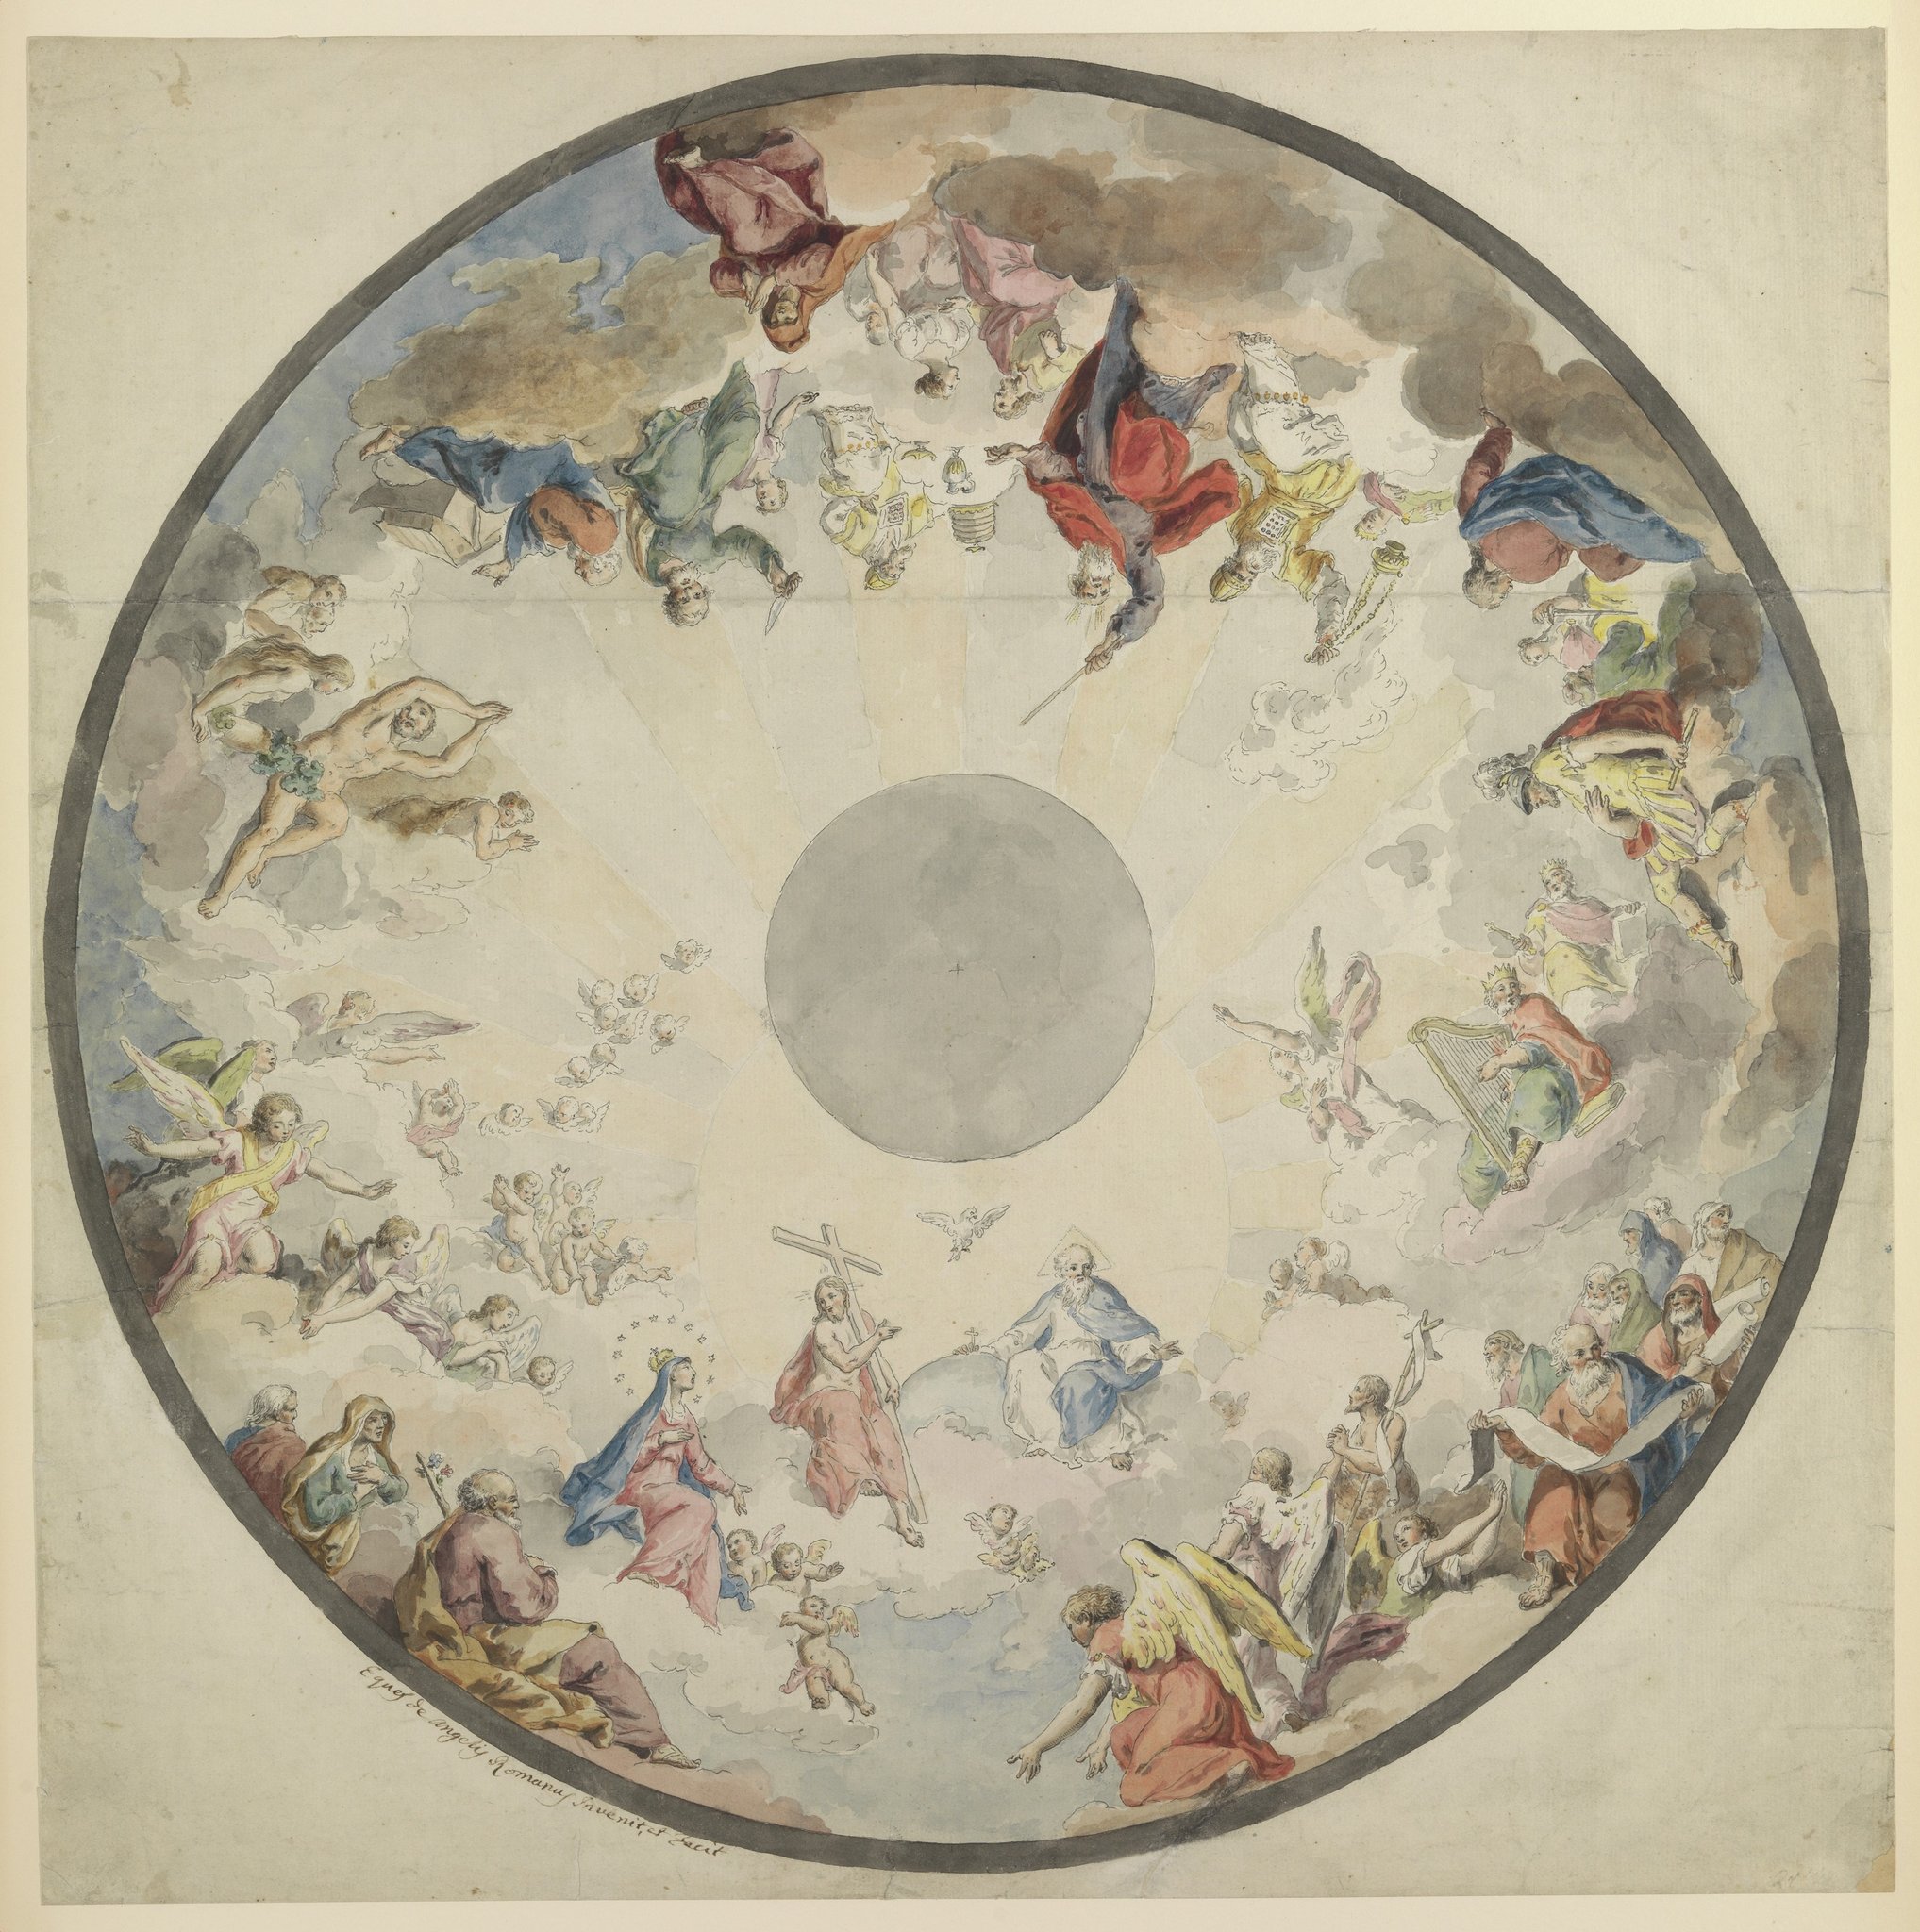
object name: drawing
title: Design for a Cupola with Old and New Testament Figures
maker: pietro de angelis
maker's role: artist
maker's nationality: italian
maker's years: 1769-1825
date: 1720-1804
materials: watercolor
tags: birds,putti,angels